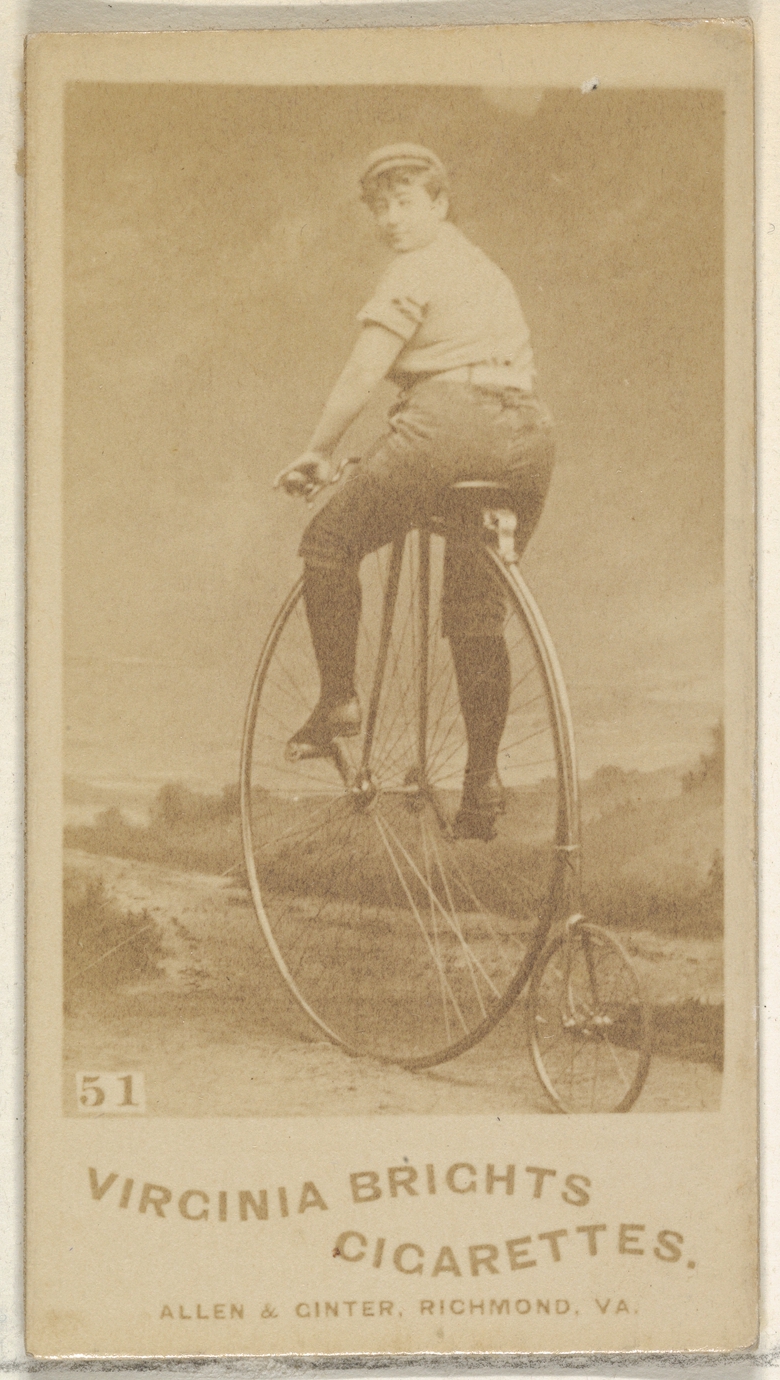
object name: photograph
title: Card 51, from the Girl Cyclists series (N49) for Virginia Brights Cigarettes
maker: allen & ginter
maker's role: publisher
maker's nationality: american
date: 1887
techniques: albumen silver print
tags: portraits,women,bicycles